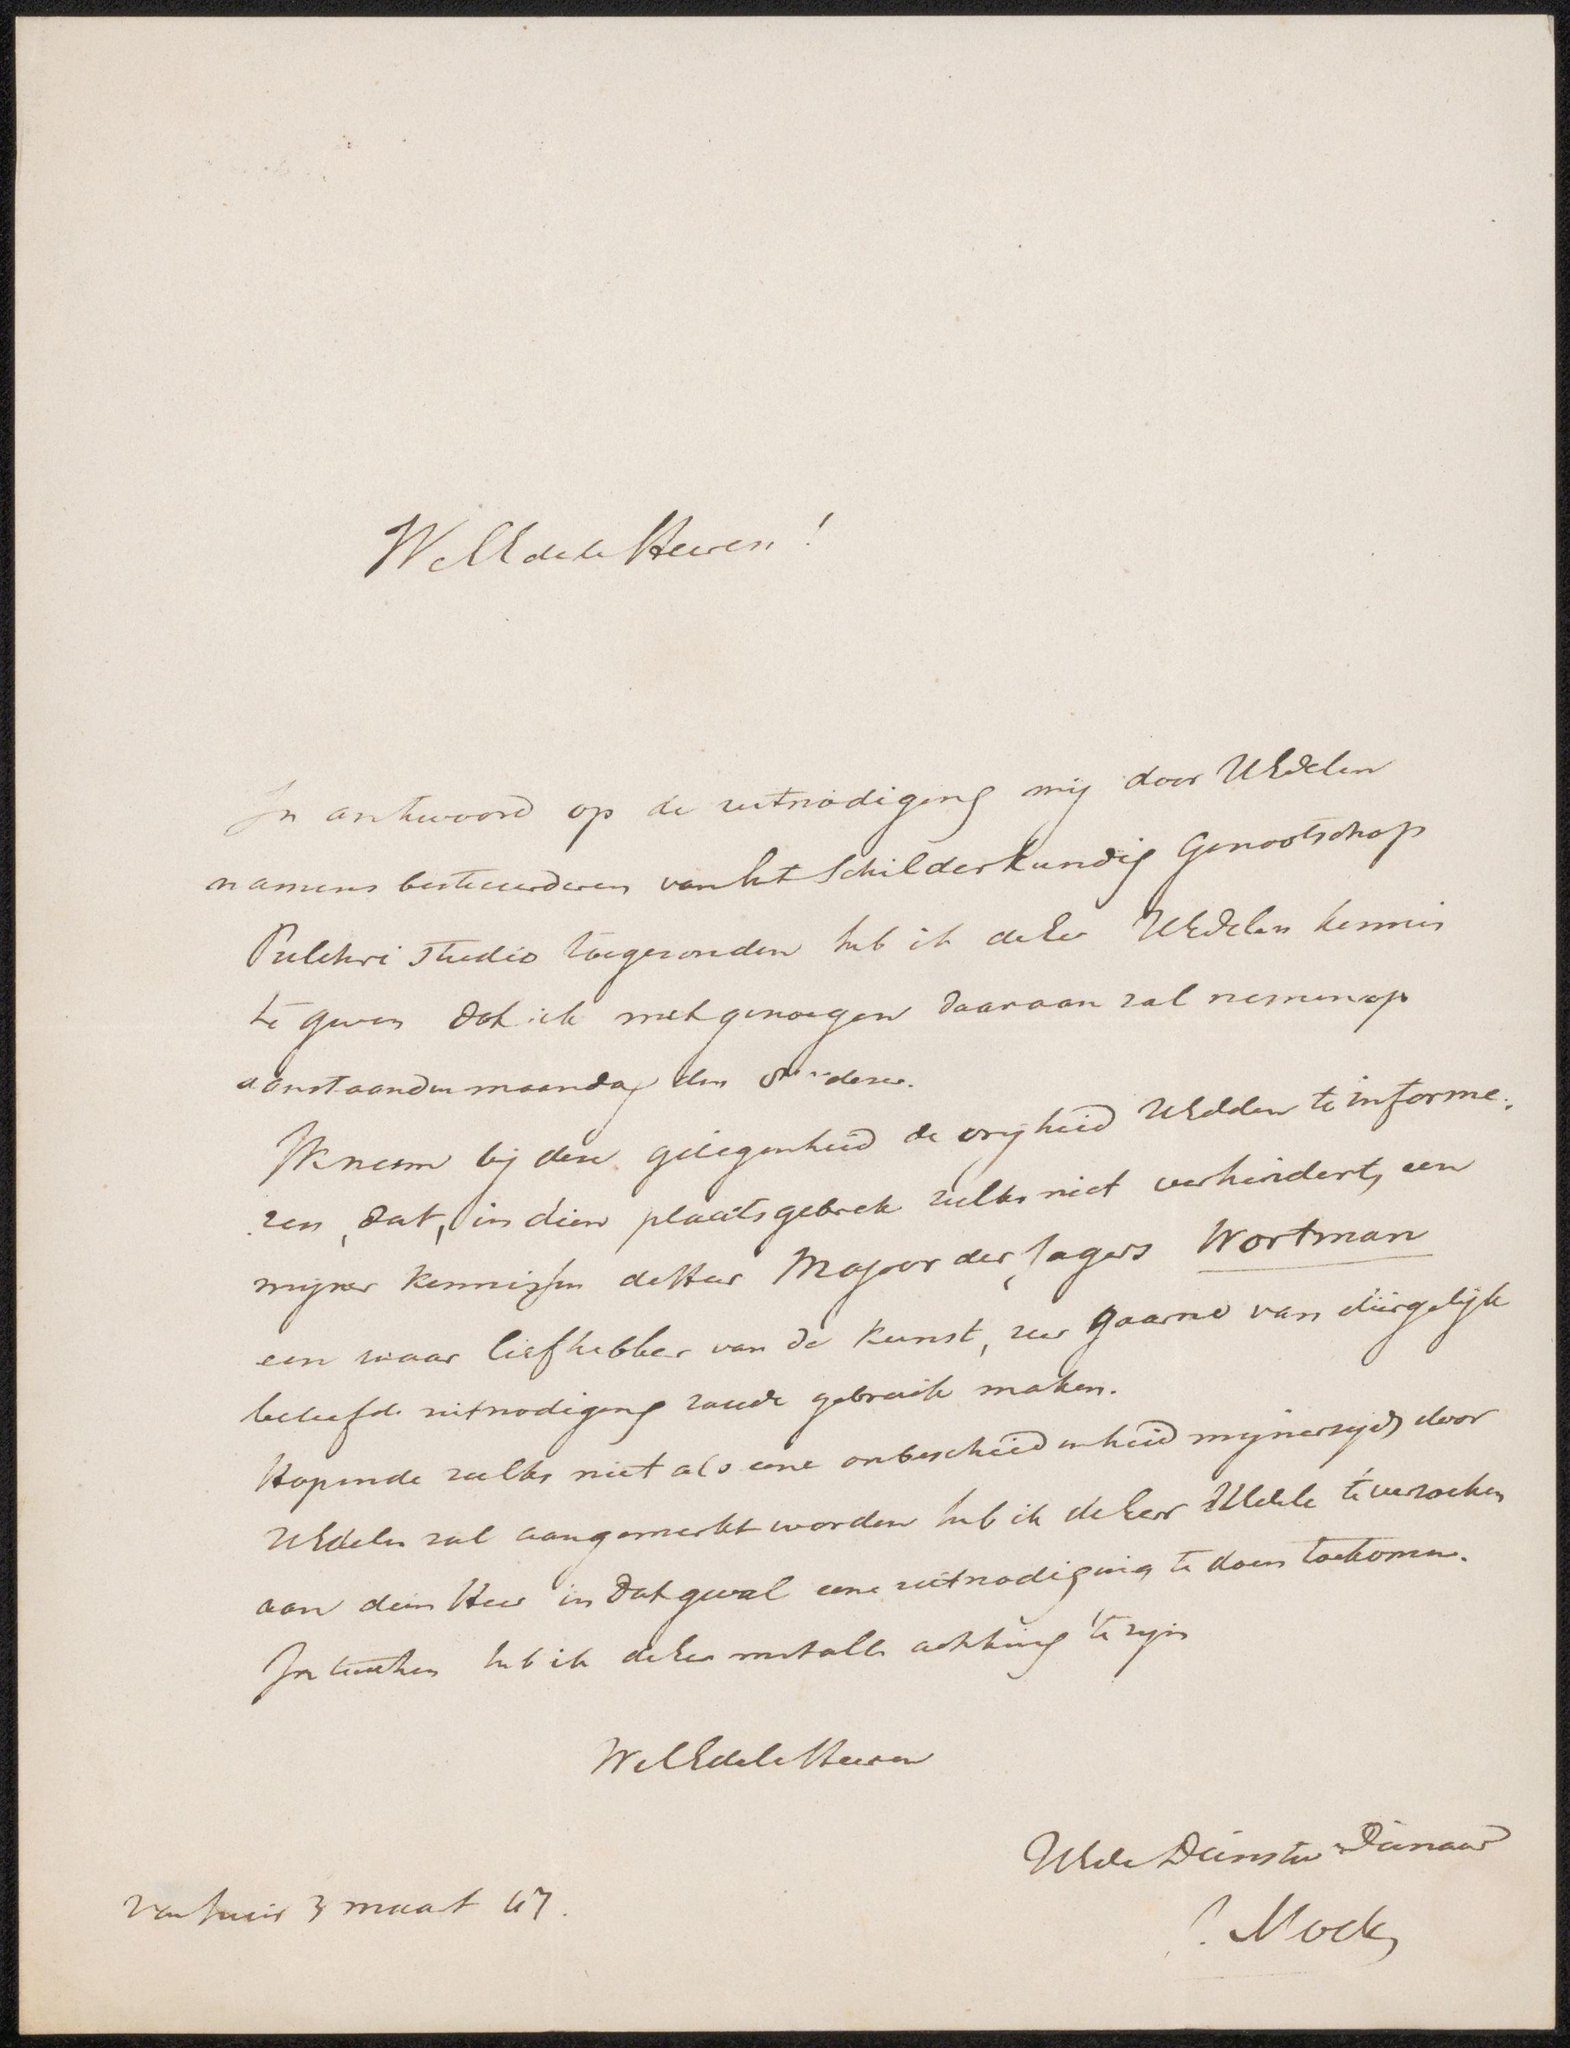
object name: letter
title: Brief aan Lambertus Hardenburg en Jan Weissenbruch, commissarissen van de kunstbeschouwing in Pulchri Studio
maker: johannes mock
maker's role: draughtsman, painter, print maker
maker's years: 1800-1884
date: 1847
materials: ink, paper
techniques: pen, writing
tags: the hague, painter, print maker, jan weissenbruch, draughtsman, lambertus hardenberg (1822-1900), criticizing and discussing art, art criticism